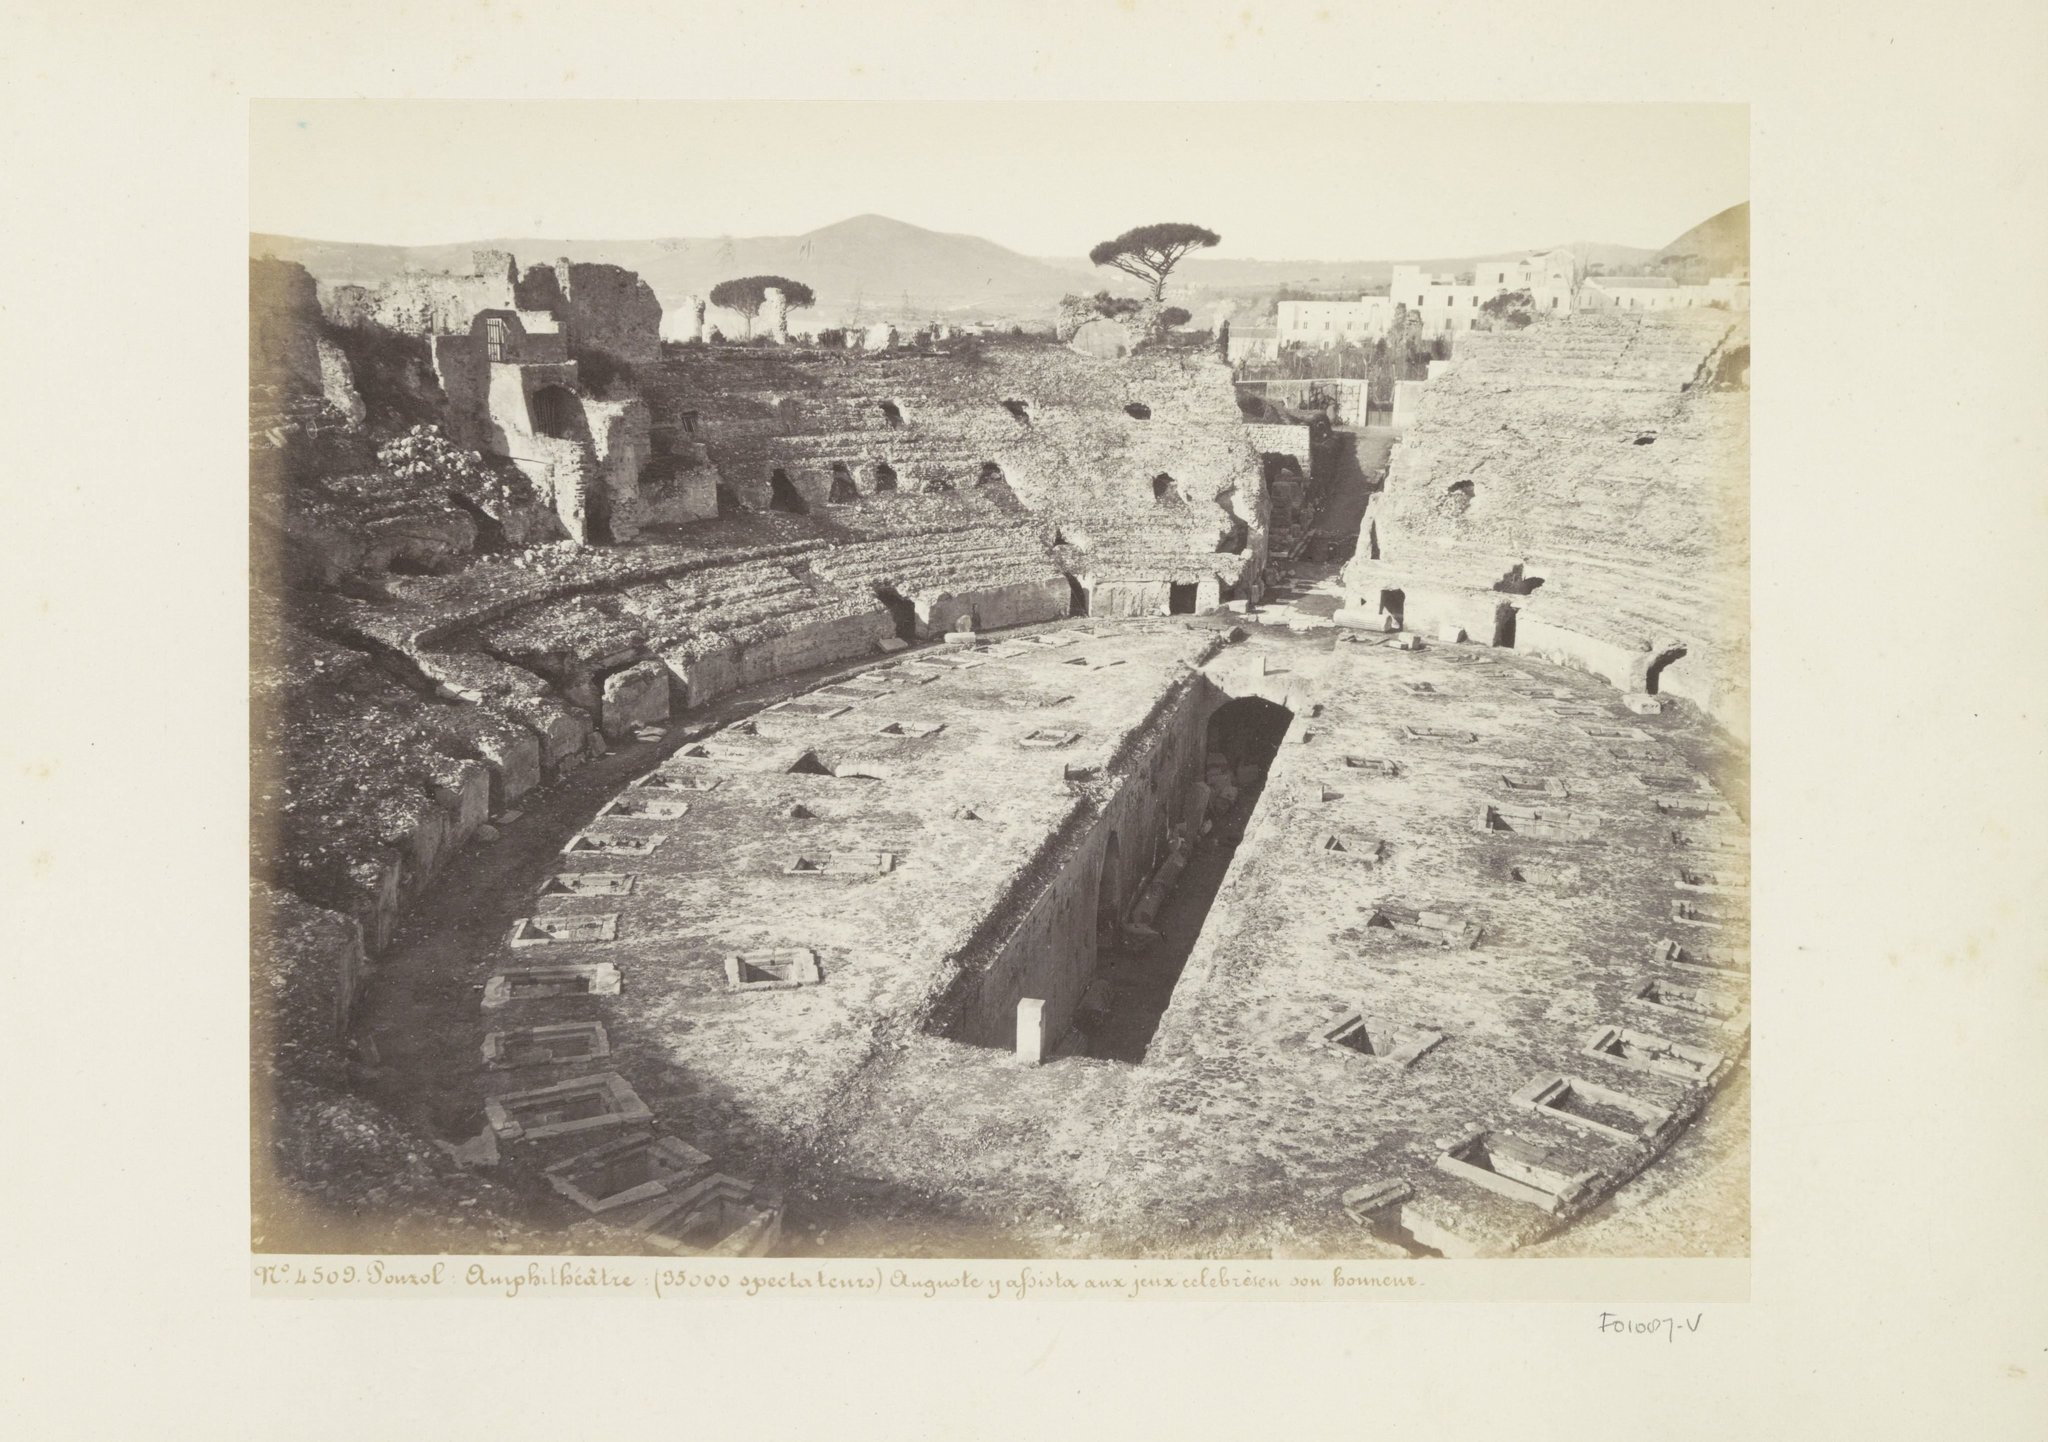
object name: photograph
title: Pouzol: Amphithéâtre: (35000 spectateurs) Auguste y assista aux jeux celebrèsen son honneur.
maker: Anonymous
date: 1865-1875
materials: paper, photographic support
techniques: albumen print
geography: pozzuoli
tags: theatre (building) - aa - open-air performances, pozzuoli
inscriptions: negative number: ‘4509’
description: Onderdeel van Reisalbum met foto's van bezienswaardigheden in Napels en omgeving.